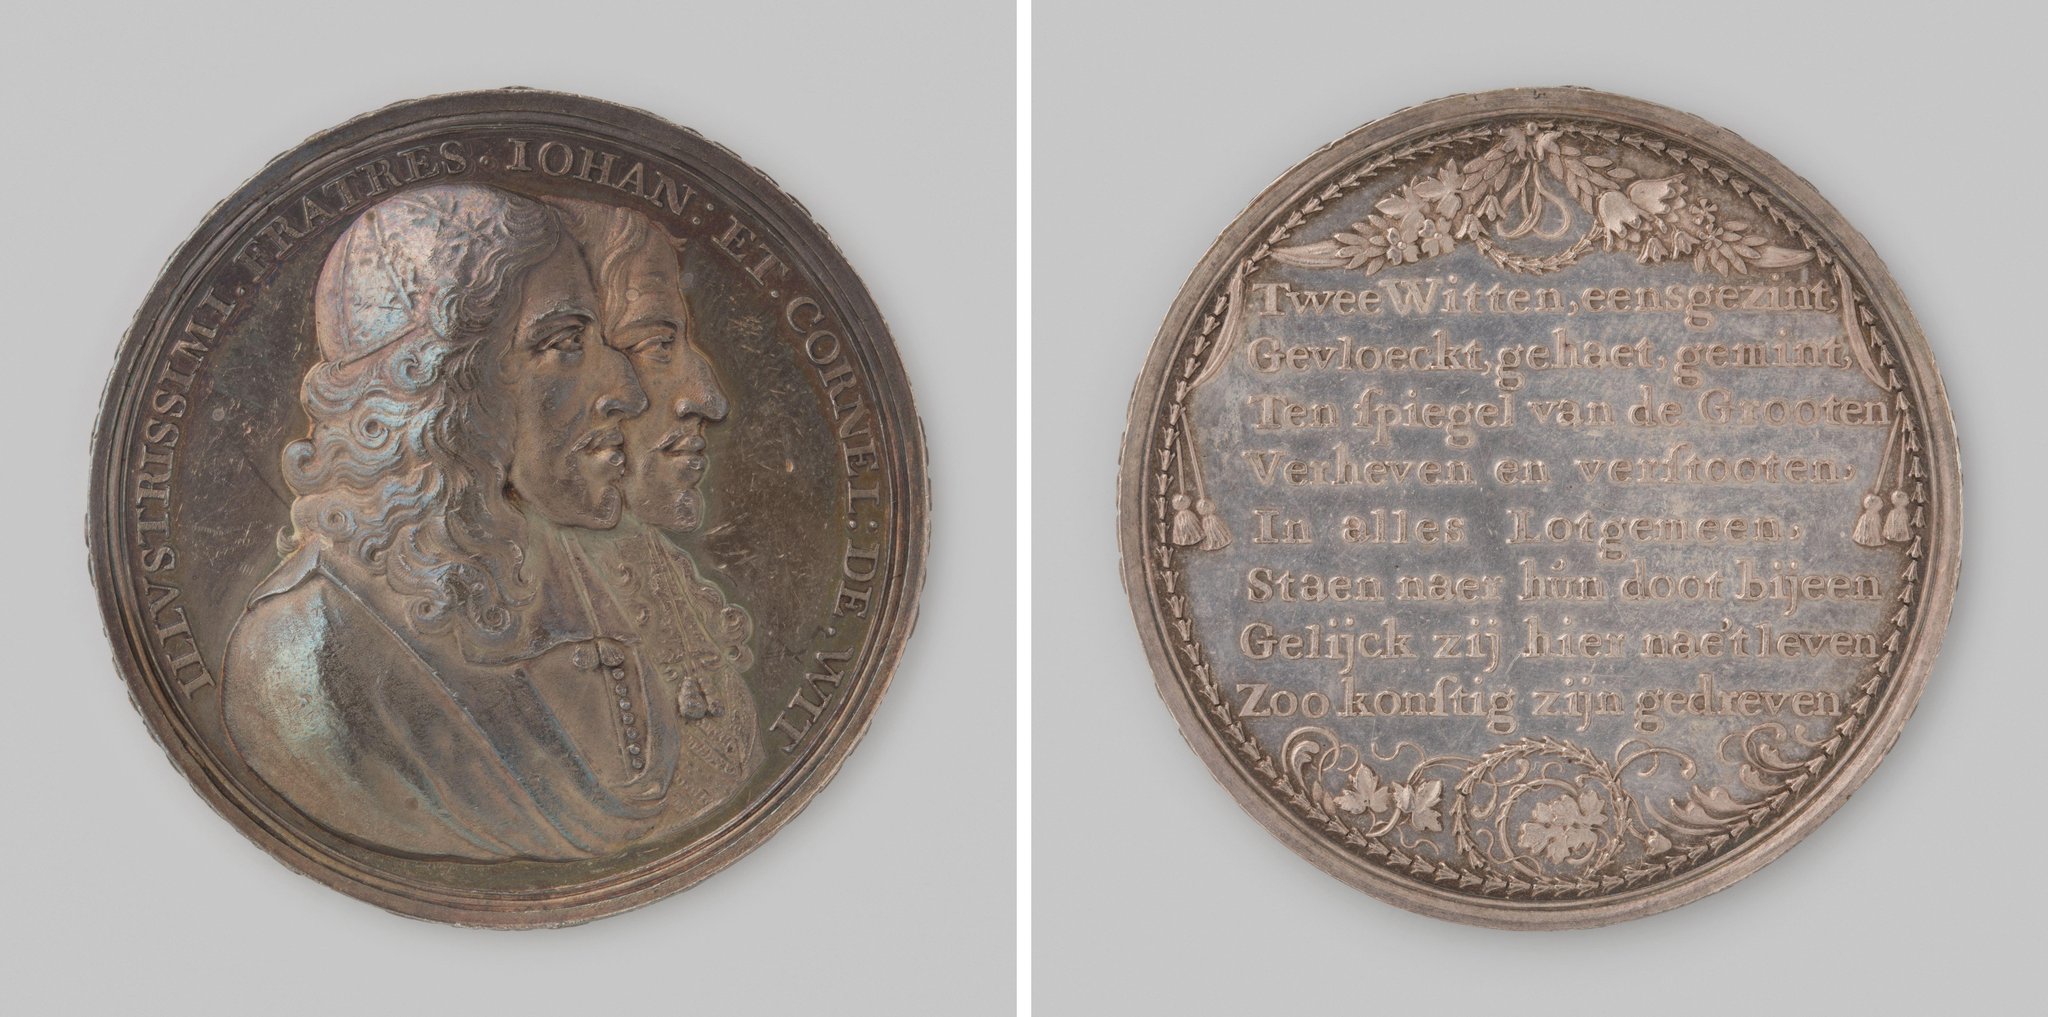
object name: history medal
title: Gebroeders De Witt vermoord 1672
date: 1672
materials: silver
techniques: striking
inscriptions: edge inscription: ‘VIOLENTIA MORTE DELETI. HAGÆ COMITIS.20 AVG: A'O. 1672. (roosje)’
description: Zilveren penning, op de voorzijde de geconjugeerde borstbeelden van Johan en Cornelis de Witt, met omschrift, op de keerzijde acht regels tekst binnen een krans versierd met bladranken, de rand met een opwaarts randschrift..